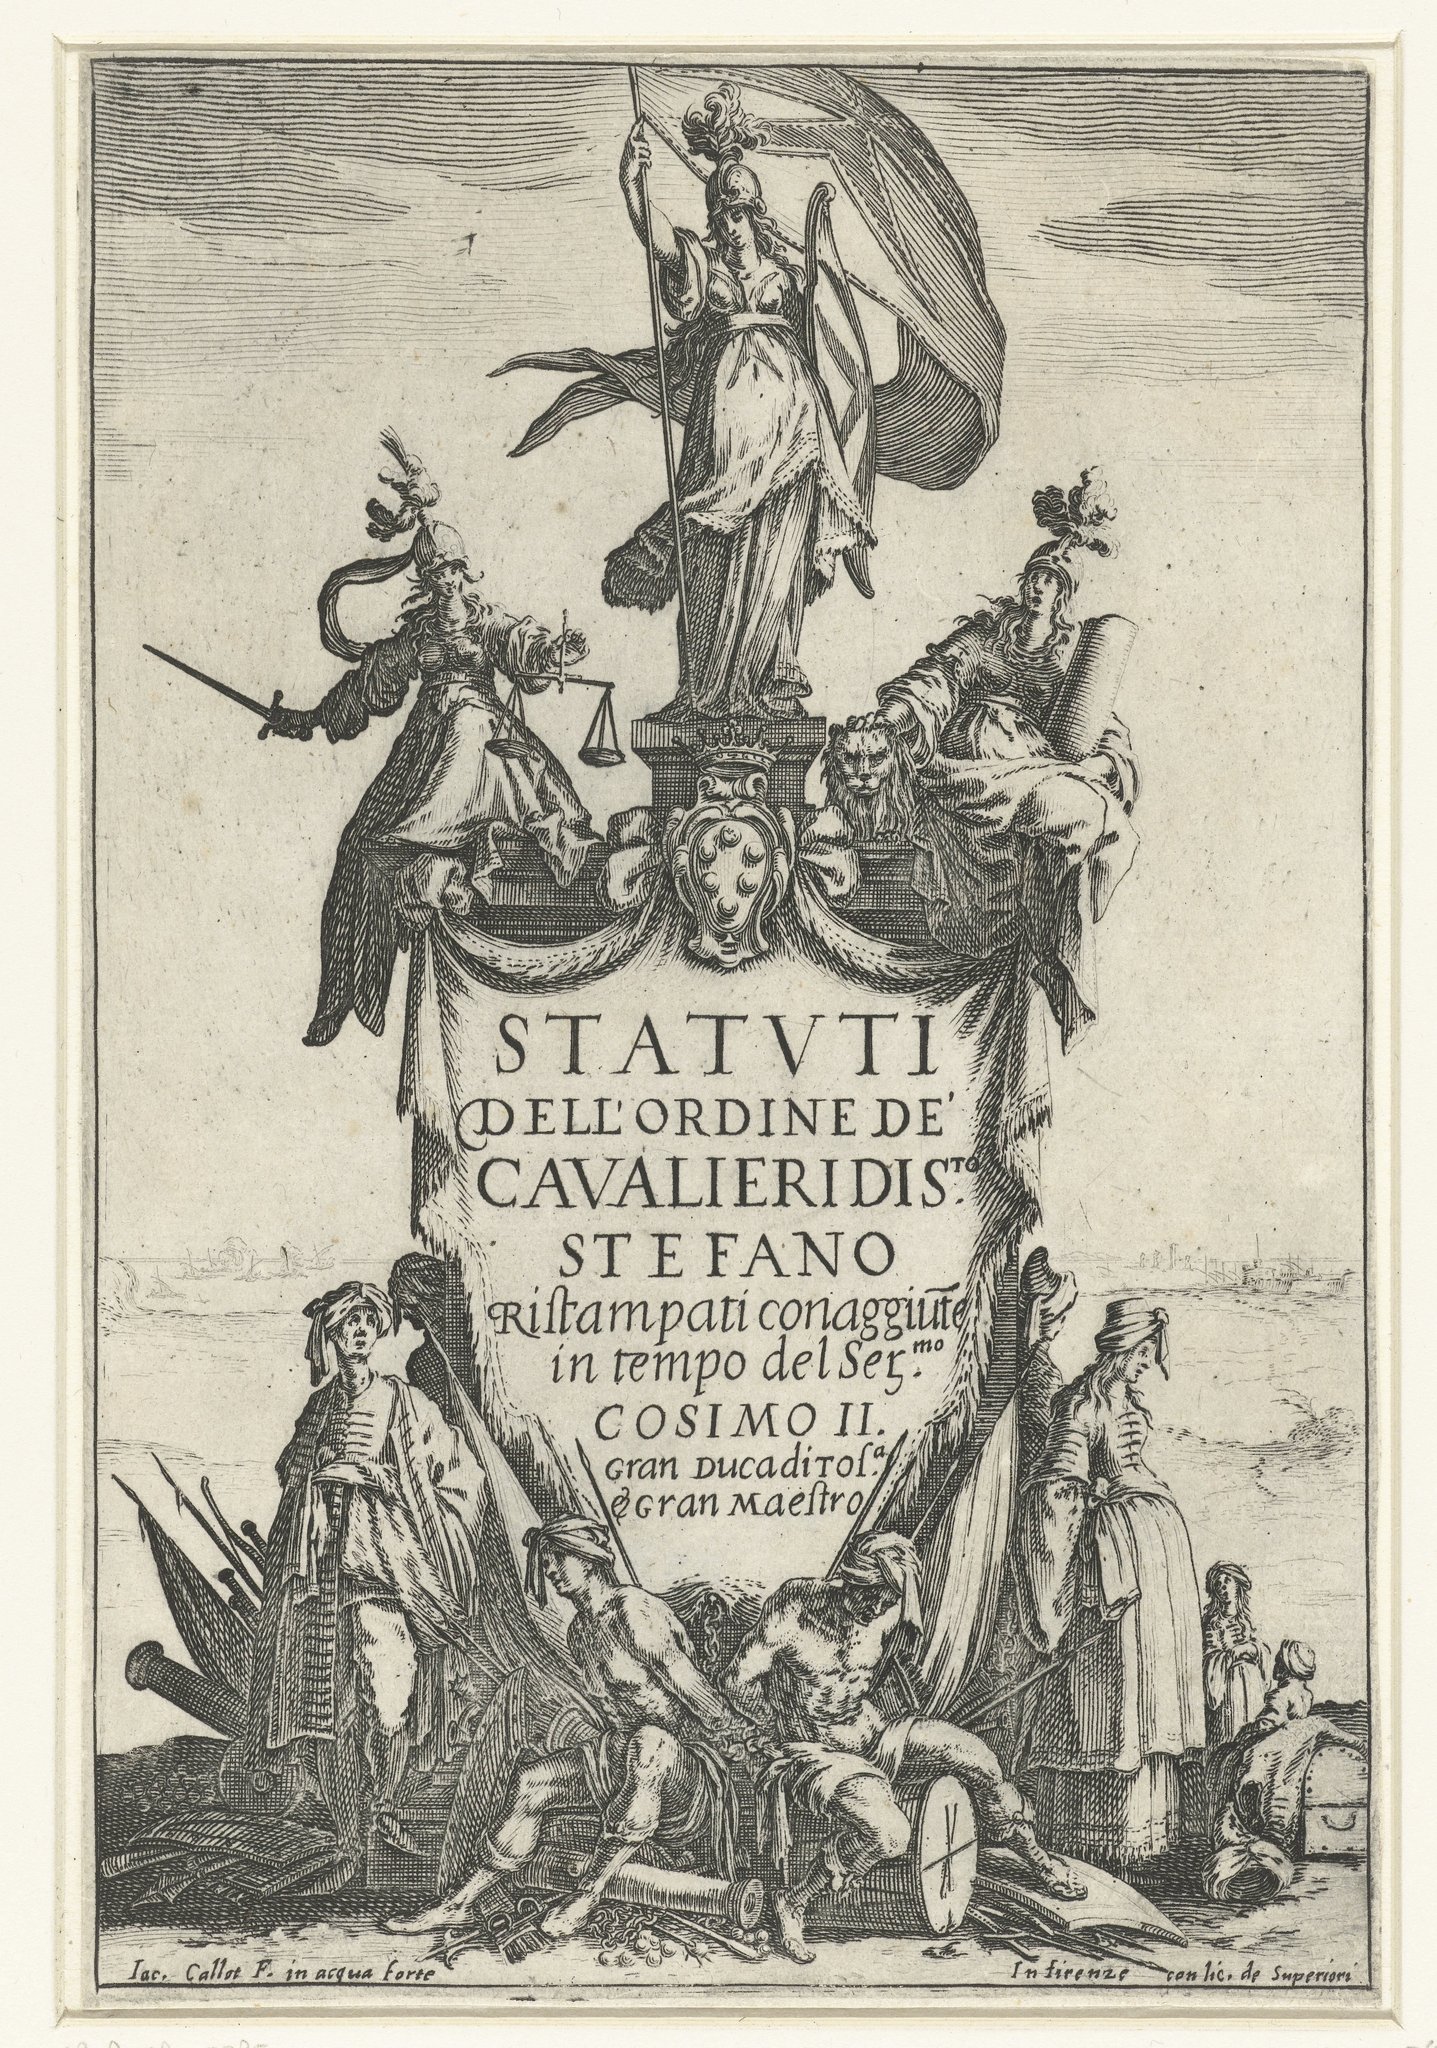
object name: print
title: Statuti dell'ordine de' Cavalieri di Santo Stefano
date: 1620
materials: paper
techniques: etching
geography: florence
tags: fortitude, 'fortitudo' ~ one of the four cardinal virtues, justice, 'justitia'; 'giustitia divina' (ripa) ~ one of the four cardinal virtues, asiatic races and peoples: turks, title-page, monument, statue, military orders, e.g.: knights templars, knights of malta, teutonic knights ~ roman catholic church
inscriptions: collector's mark: Lugt 2228a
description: Latijnse tekst op een doek, bevestigd aan een monument met personificaties van rechtvaardigheid en kracht, en een dame met een vaandel en schild waarop het kruis van de Maltezer Ridders. Aan de voet van het monument wapentuig en Turkse gevangenen.